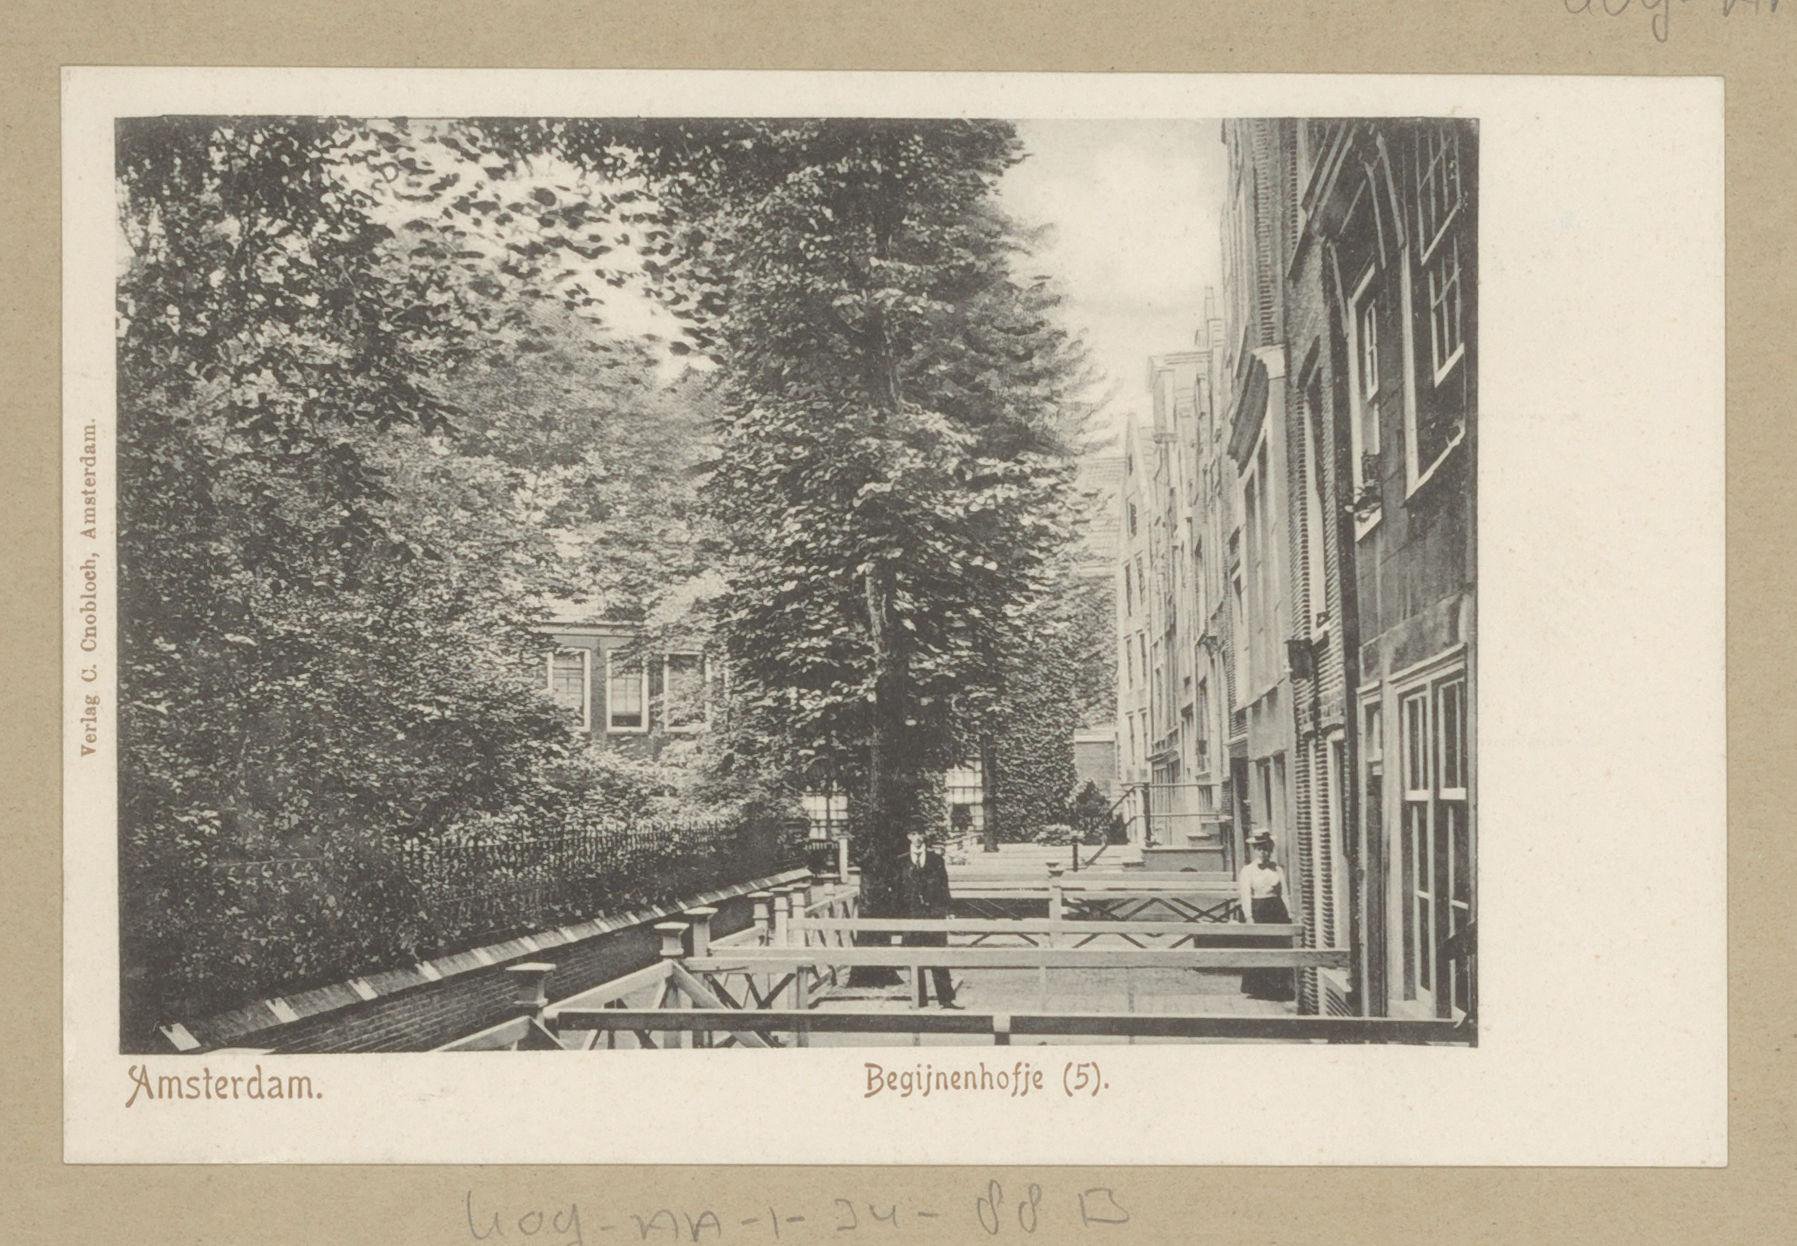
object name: ansichtkaart, prentbriefkaart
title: Gezicht op het Begijnhof te Amsterdam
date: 1892-1905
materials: paper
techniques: photograph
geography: amsterdam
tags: street (+ city(-scape) with figures, staffage)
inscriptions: collector's mark: Lugt 1641b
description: Onderwerpsrubriek binnen de Atlas Amsterdam: Kerkwezen: R.K. Gemeenten: Begijnhof t/m Petrus en Paulus.